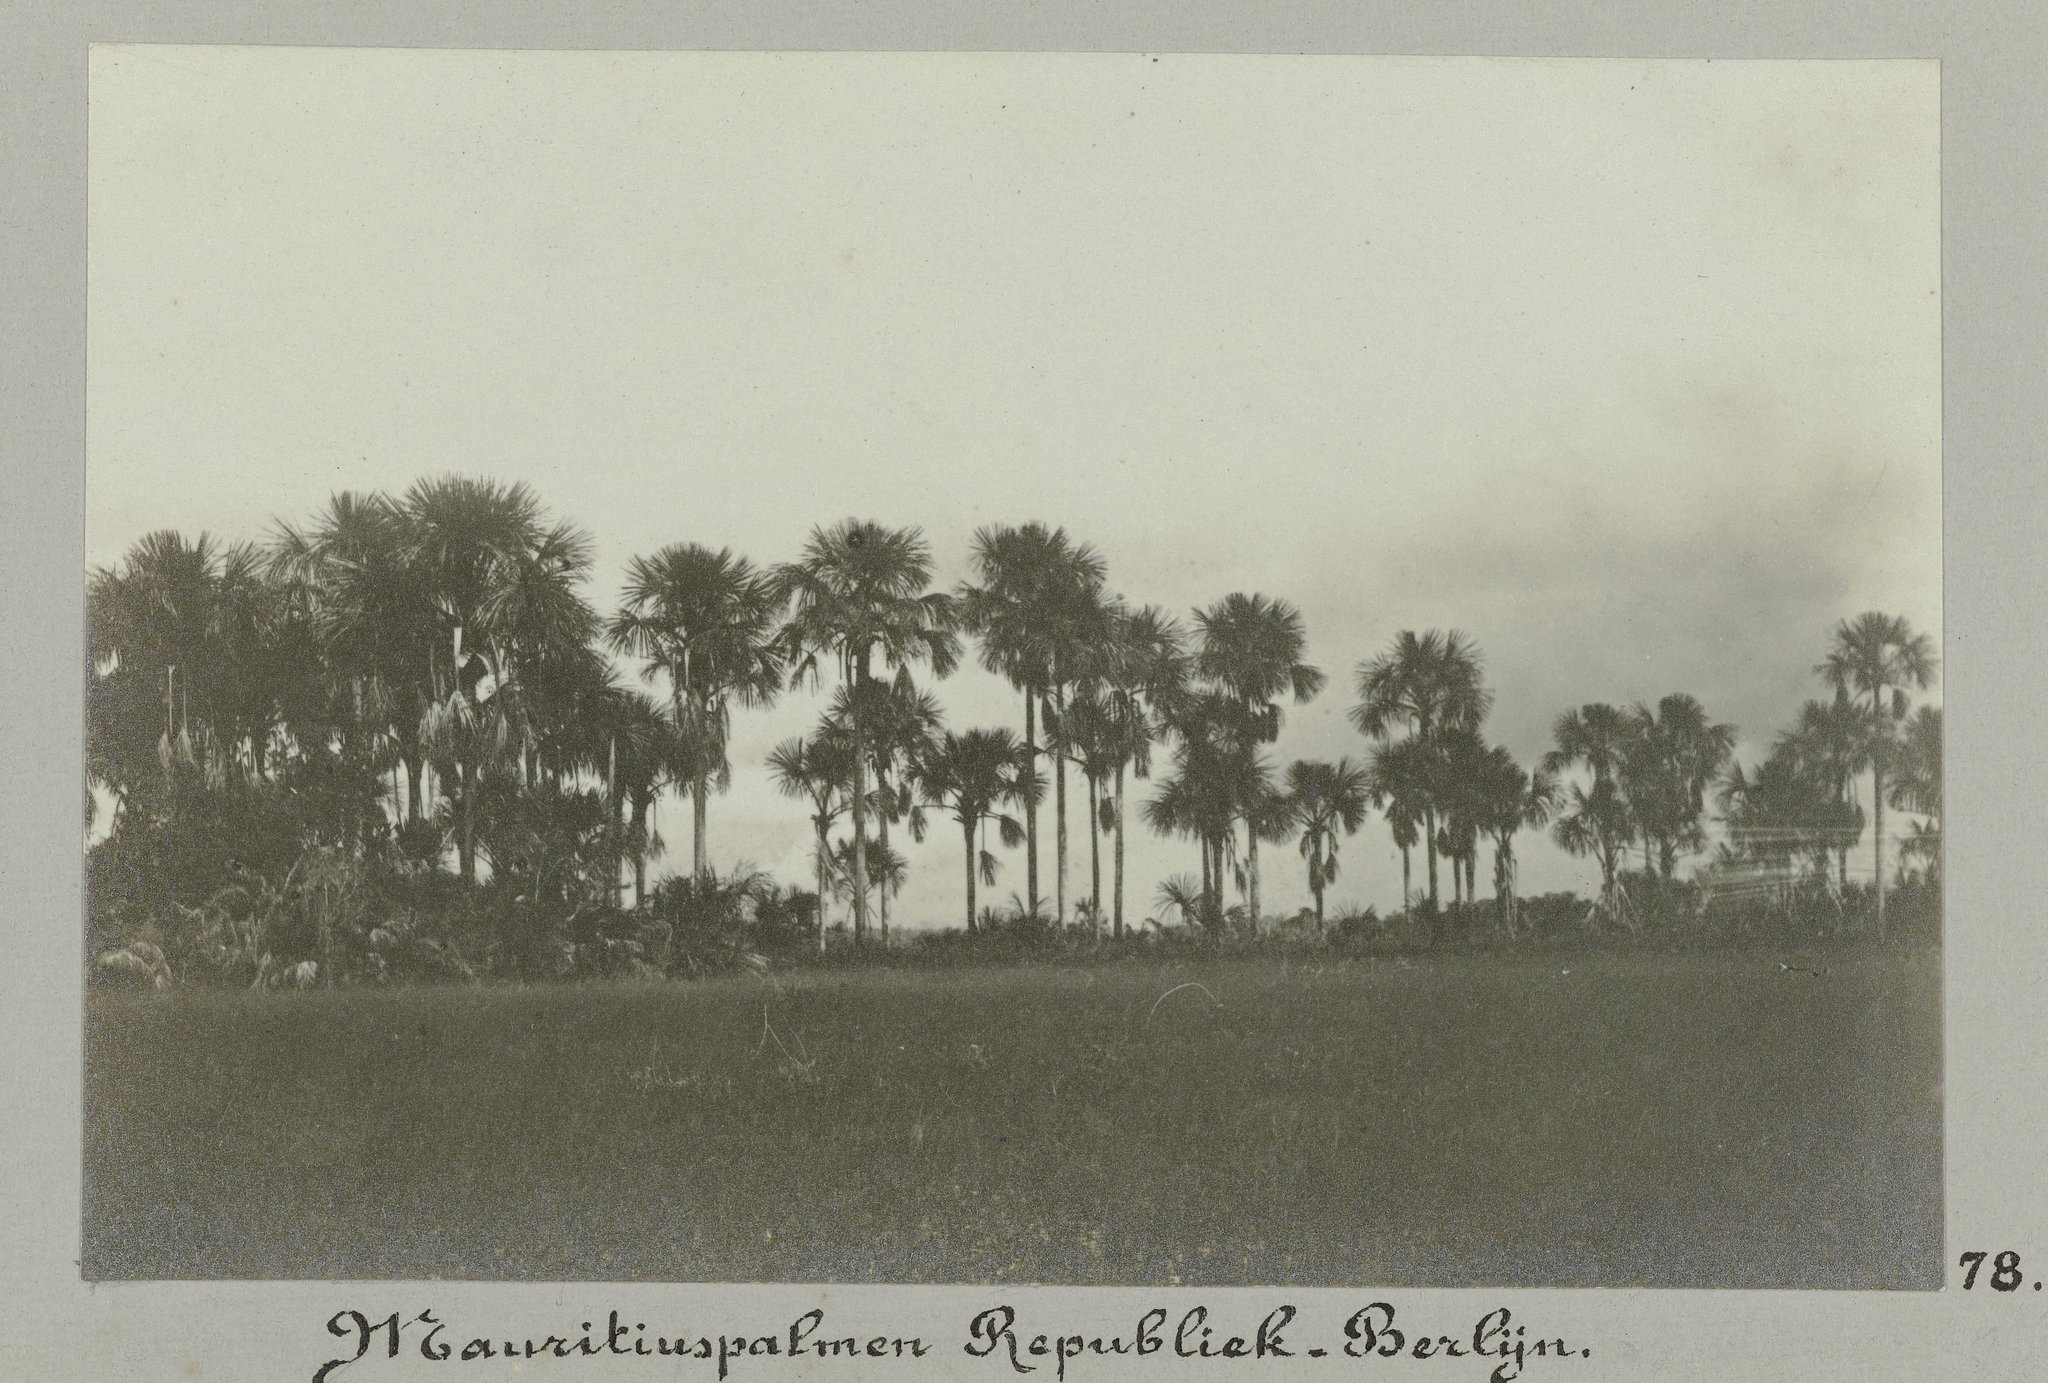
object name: photograph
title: Mauritiuspalmen Republiek-Berlijn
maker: hendrik doijer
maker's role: engineer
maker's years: 1863-1925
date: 1903-1910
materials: photographic support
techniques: gelatin silver print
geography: suriname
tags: suriname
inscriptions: inscription: ‘78. / Mauritiuspalmen Republiek-Berlijn.’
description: Een rij mauritiuspalmen (langs een weg) tussen de plaatsen Republiek en Berlijn. Onderdeel van het fotoalbum Souvenir de Voyage (deel 3), over het leven van de familie Doijer in en rond de plantage Ma Retraite in Suriname in de jaren 1903-1910.